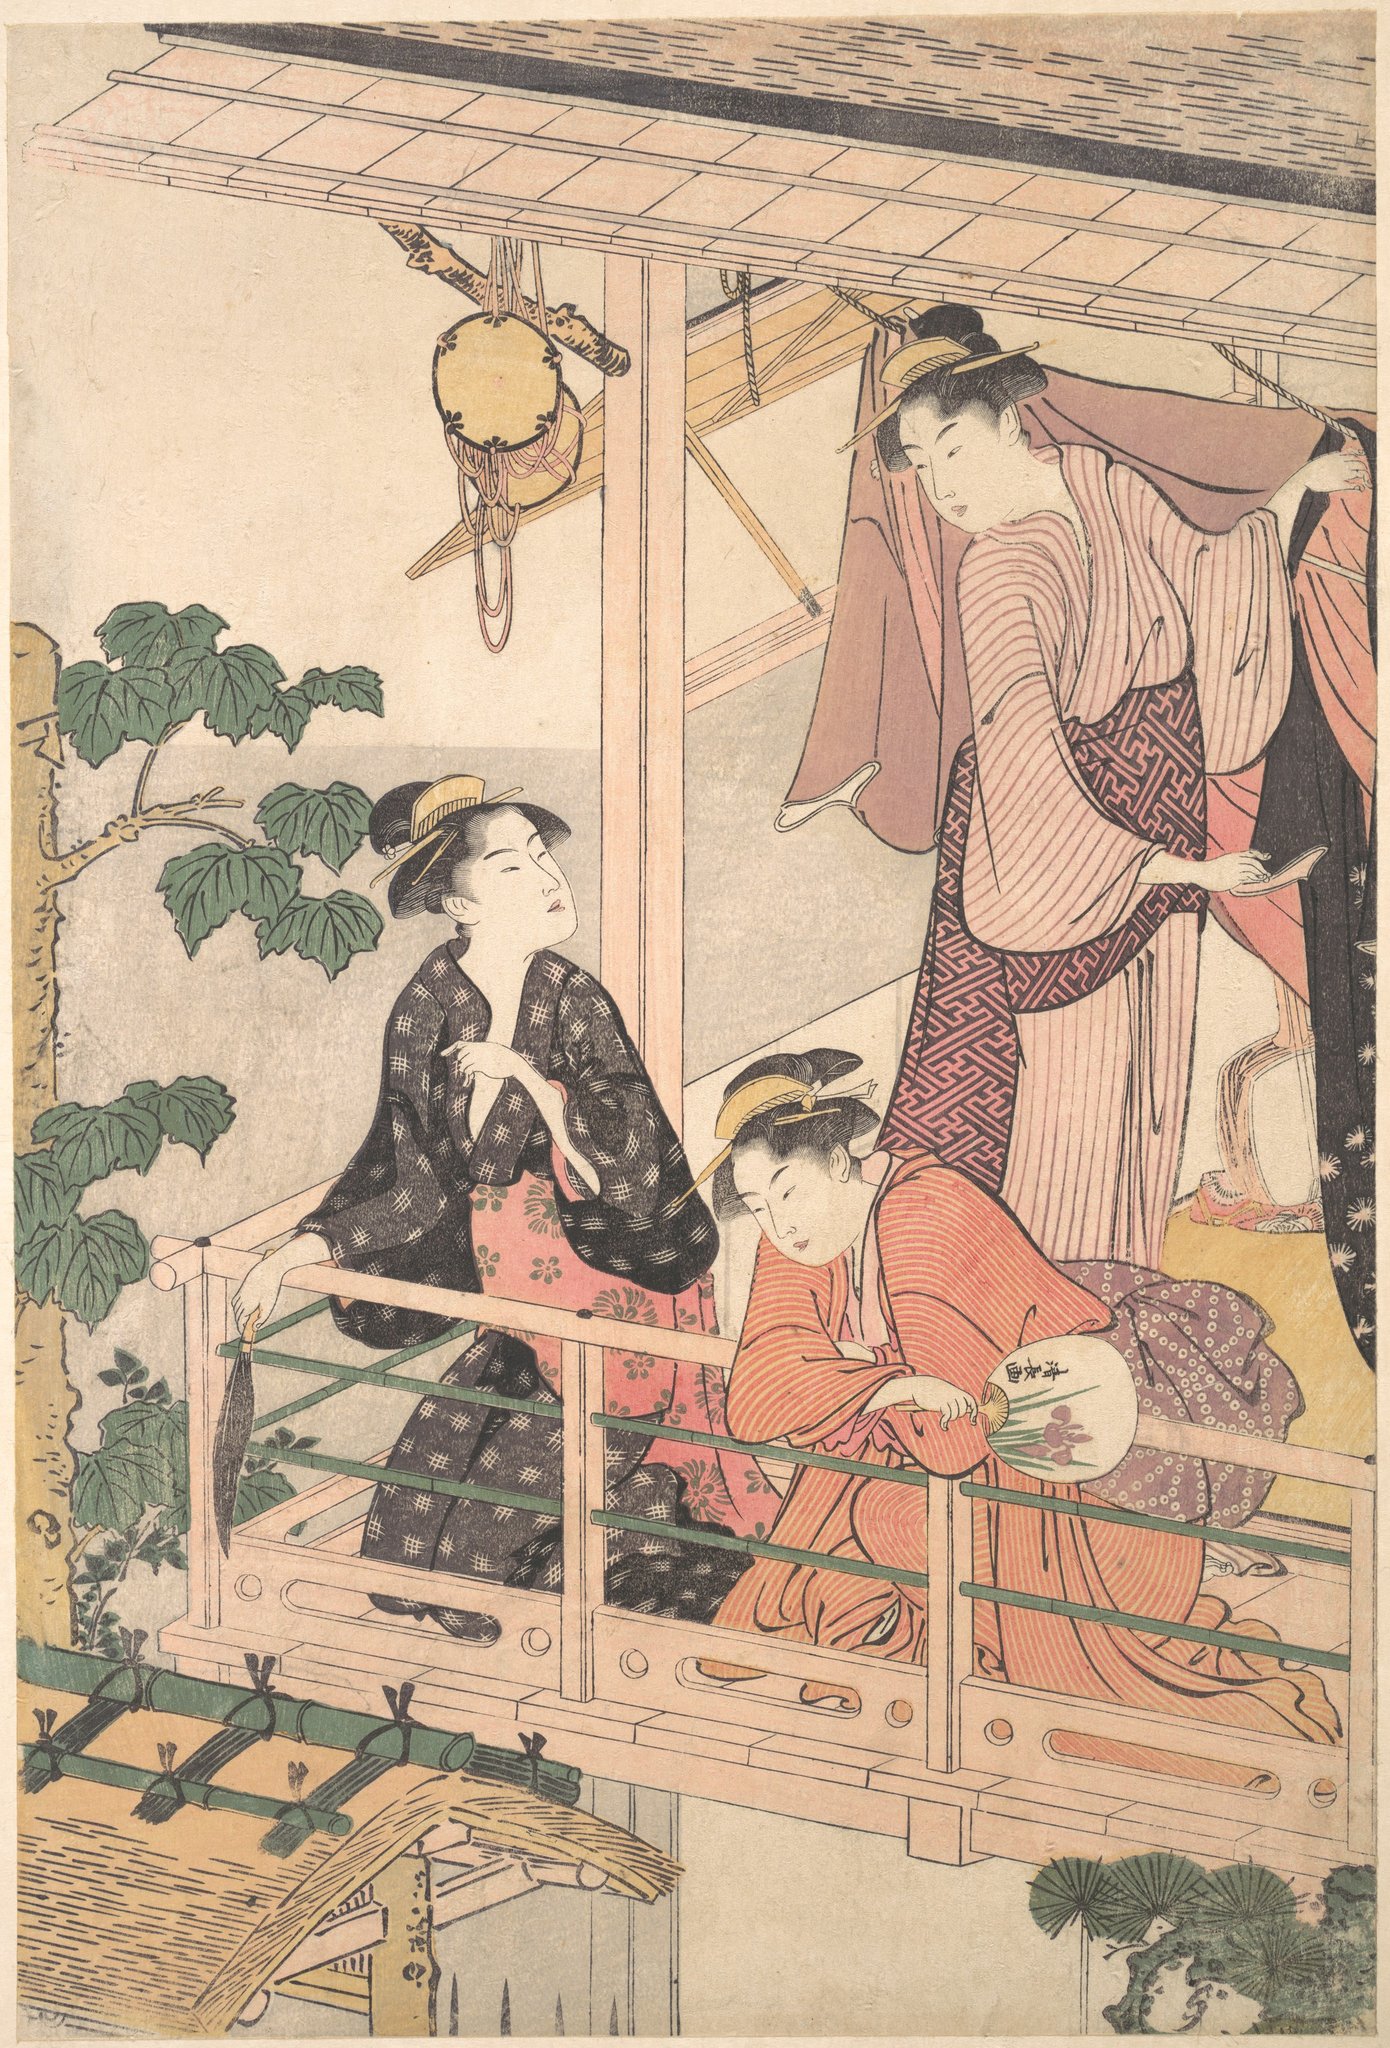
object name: print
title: Three Women on a Balcony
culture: japanese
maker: torii kiyonaga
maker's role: artist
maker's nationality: japanese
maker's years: 1752-1815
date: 1786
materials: ink, paper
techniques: woodblock print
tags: balconies,fans,women